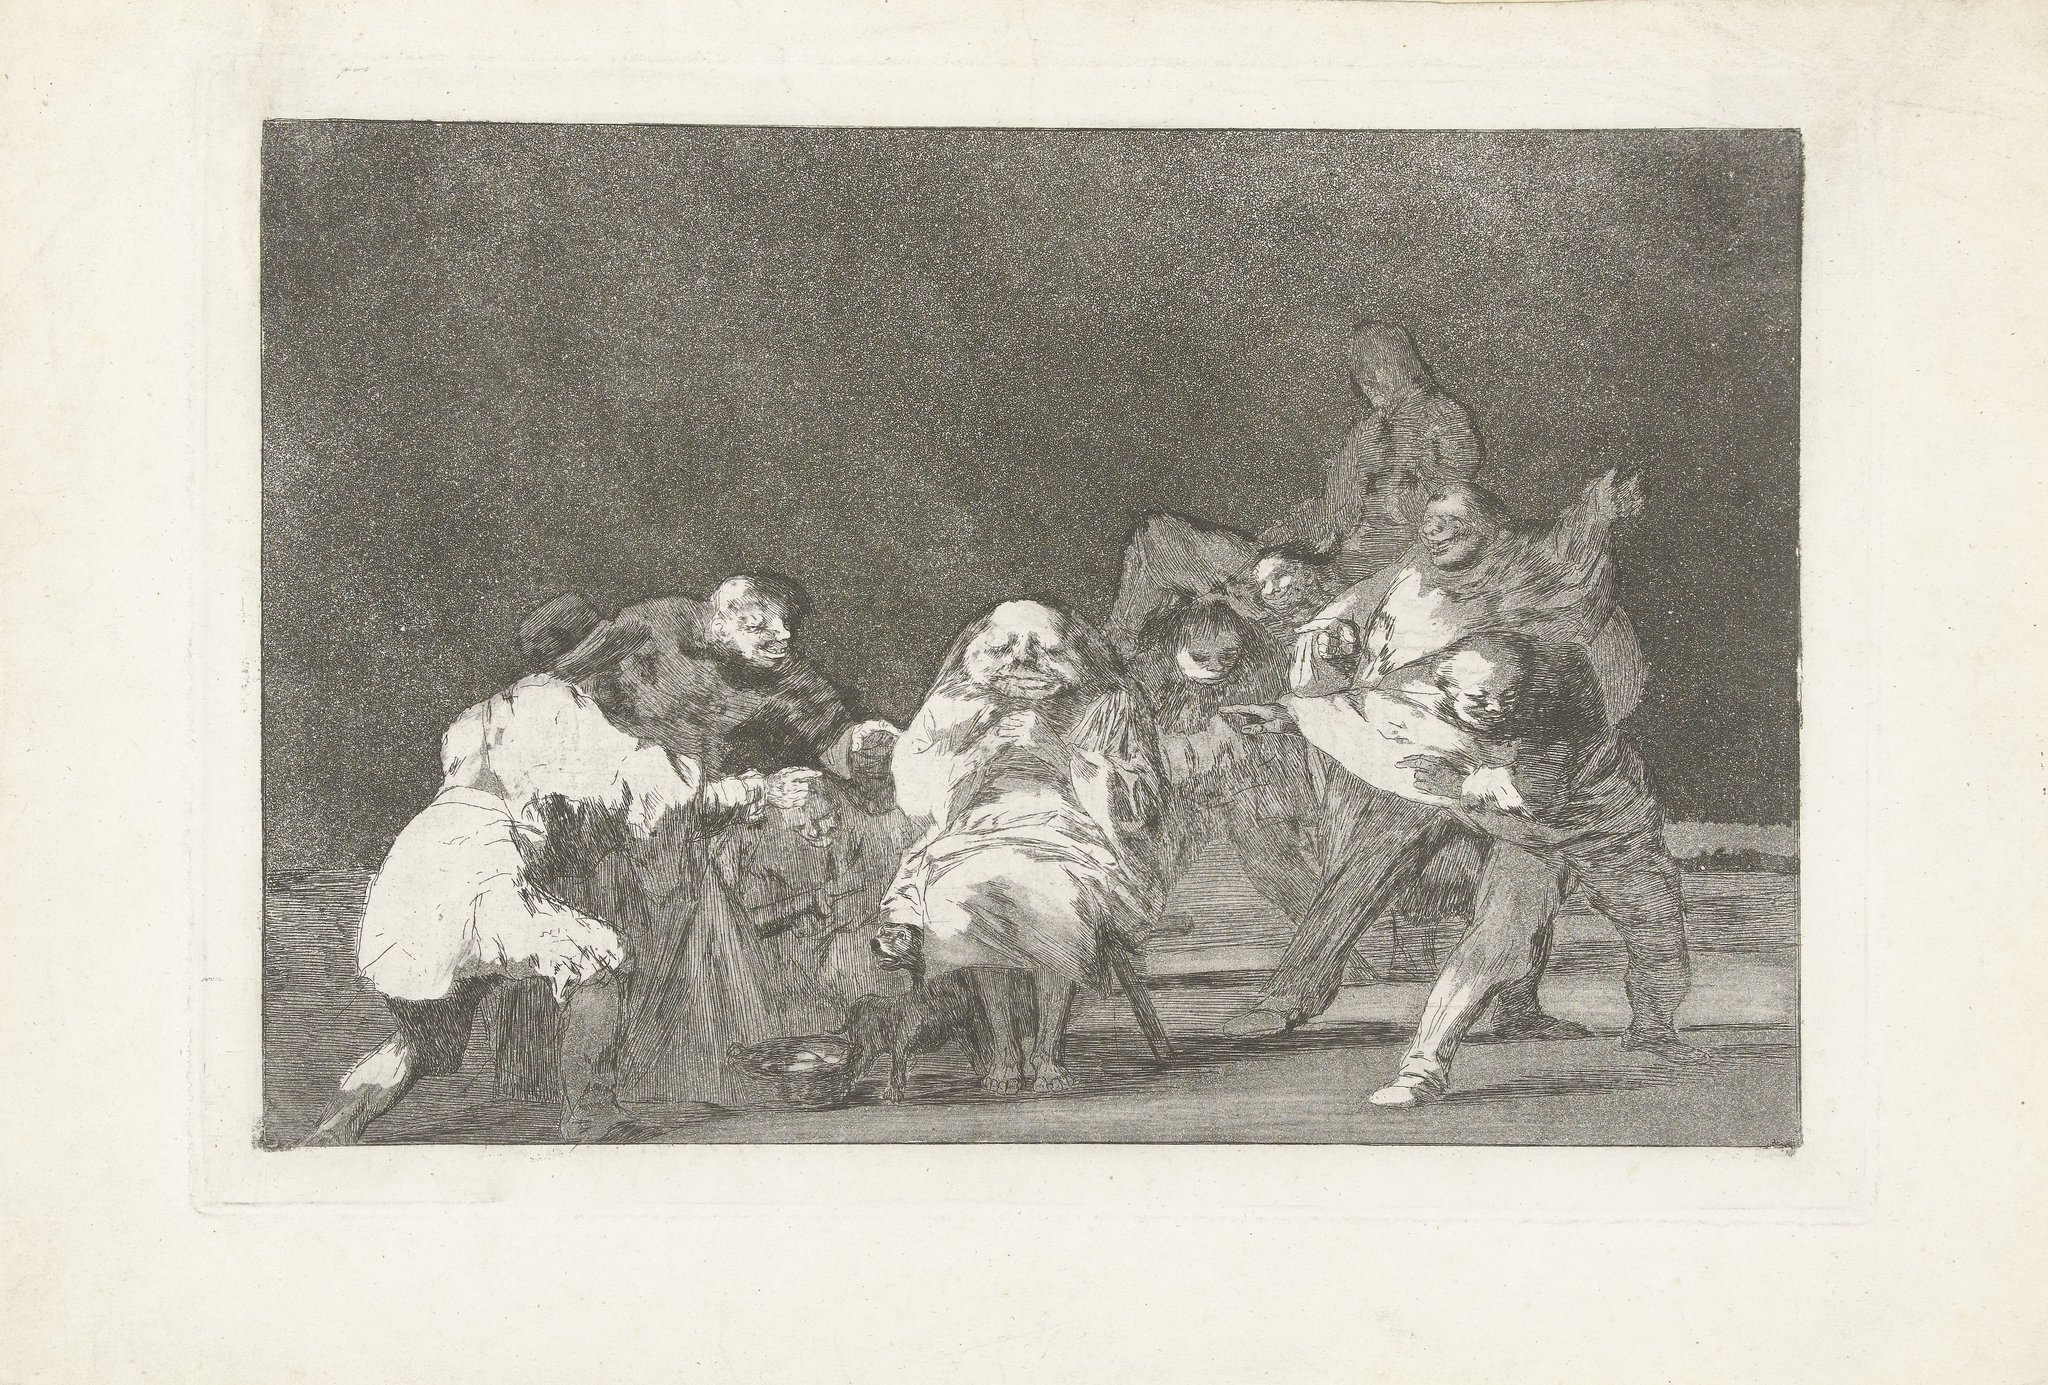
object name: print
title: De loyaliteit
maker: francisco de goya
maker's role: draughtsman, painter, print maker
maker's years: 1746-1828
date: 1815-1820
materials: paper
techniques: aquatint, etching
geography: spain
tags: frankness, loyalty; 'lealtà', 'realtà' (ripa)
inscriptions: collector's mark: Lugt 2760, collector's mark: Lugt 2228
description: De serie Los Disparates is pas na de dood van Goya uitgegeven. De Real Academia des Nobles Artes heeft de serie gepubliceerd onder de naam Los Proverbios. Harris heeft in zijn catalogus aan elke prent een Spaans spreekwoord toegekend. Deze prent verbeeldt volgens hem het spreekwoord: El que no te ama, burlando te difama (wie niet van jou houdt, zal jou bespotten). K.Botke